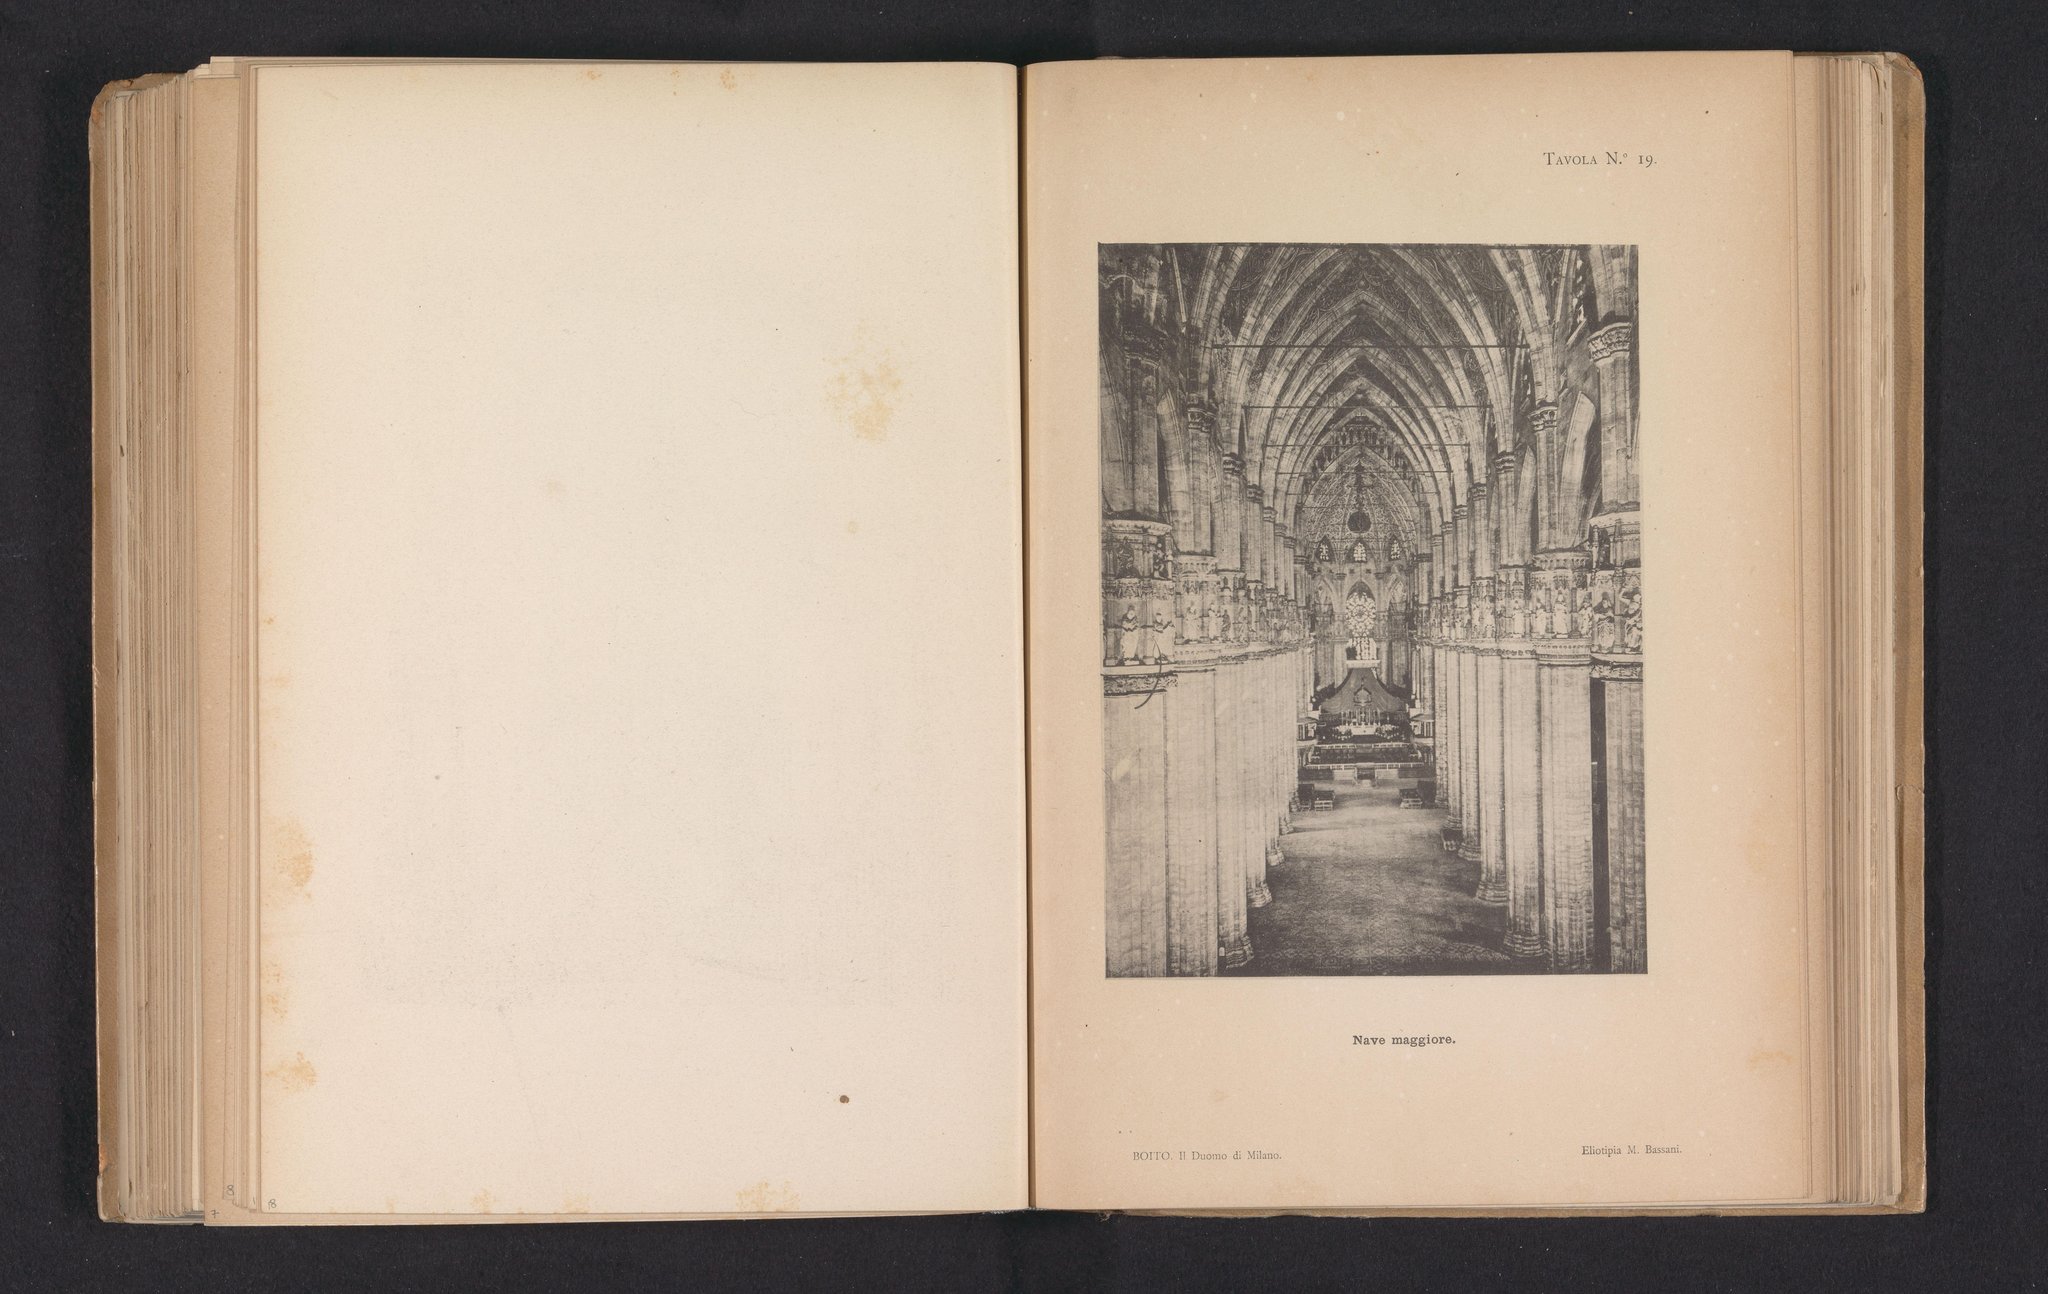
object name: page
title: Nave maggiore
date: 1879-1889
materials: paper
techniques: photograph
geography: milan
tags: parts of church interior: nave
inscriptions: number: ‘Tavola No. 19.’